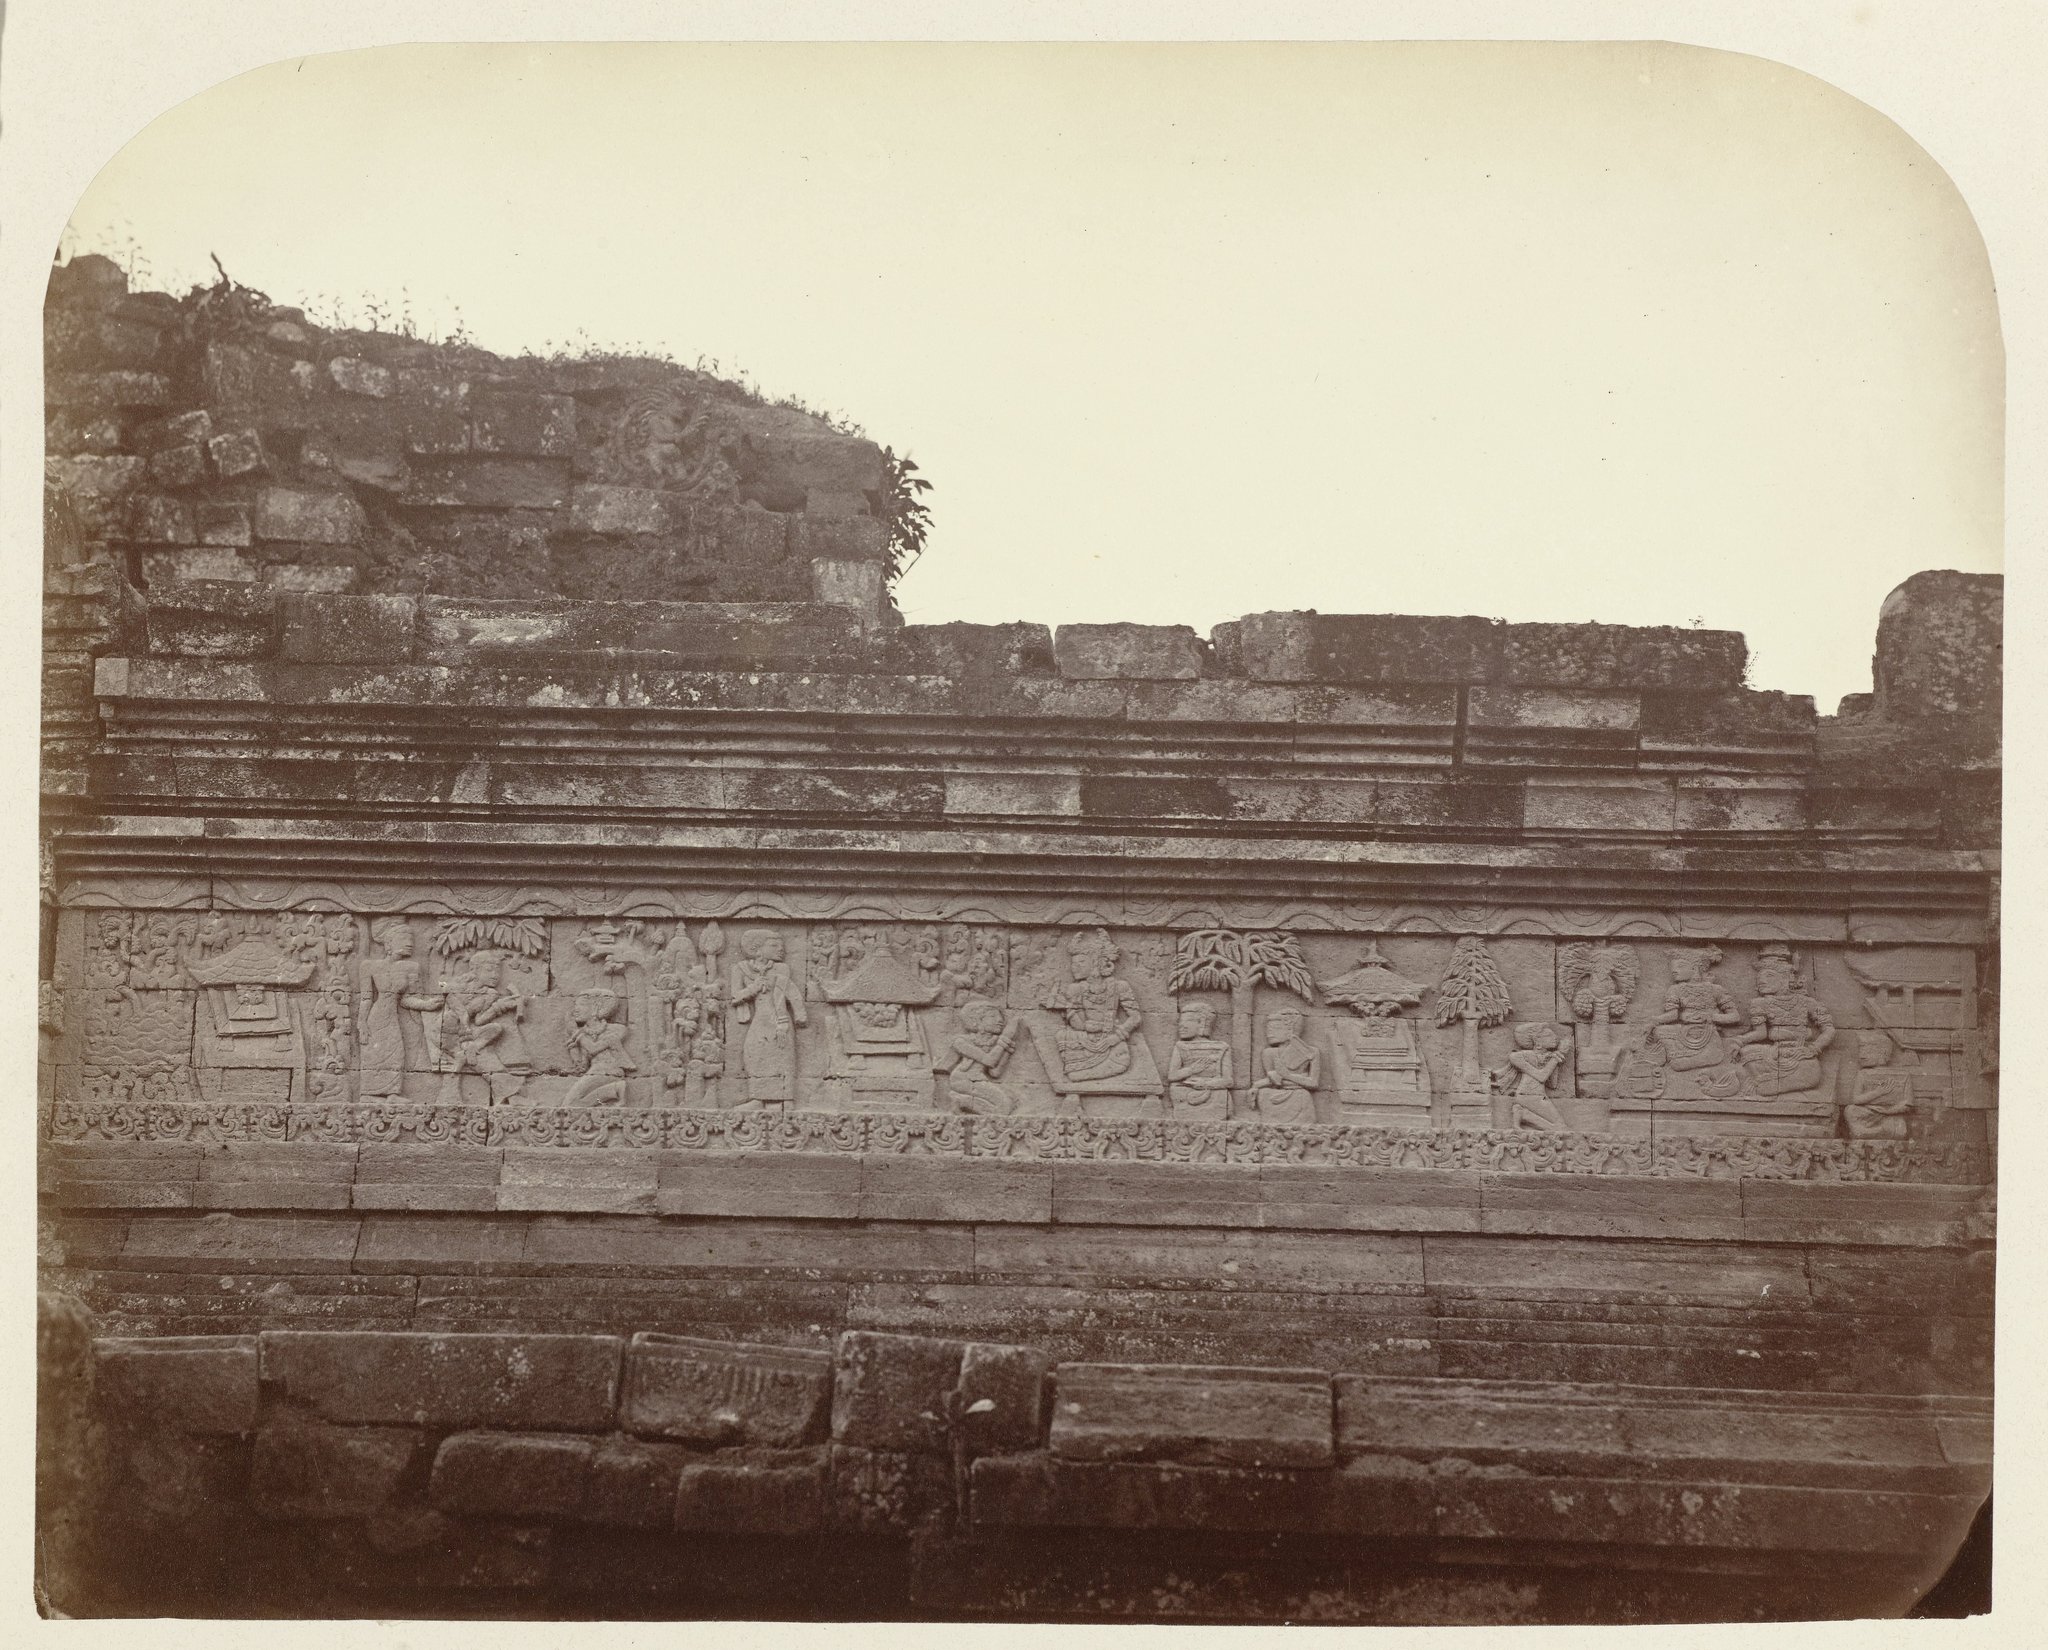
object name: photograph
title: Basreliëf van den tempel (zuidzijde) 1e gaanderij. Panataran (r. Kediri)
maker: isidore kinsbergen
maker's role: fotograaf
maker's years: 1821-1905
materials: cardboard, paper, photographic support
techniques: albumen print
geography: java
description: Candi Panataran (Temple Complex), main Temple; Krishnayana reliefs no. 16 (Preparing for Rukmini's marriage to the king of Cedi), second narrative register, south side. Panataran, Blitar district, East Java province 1323-1347 AD.